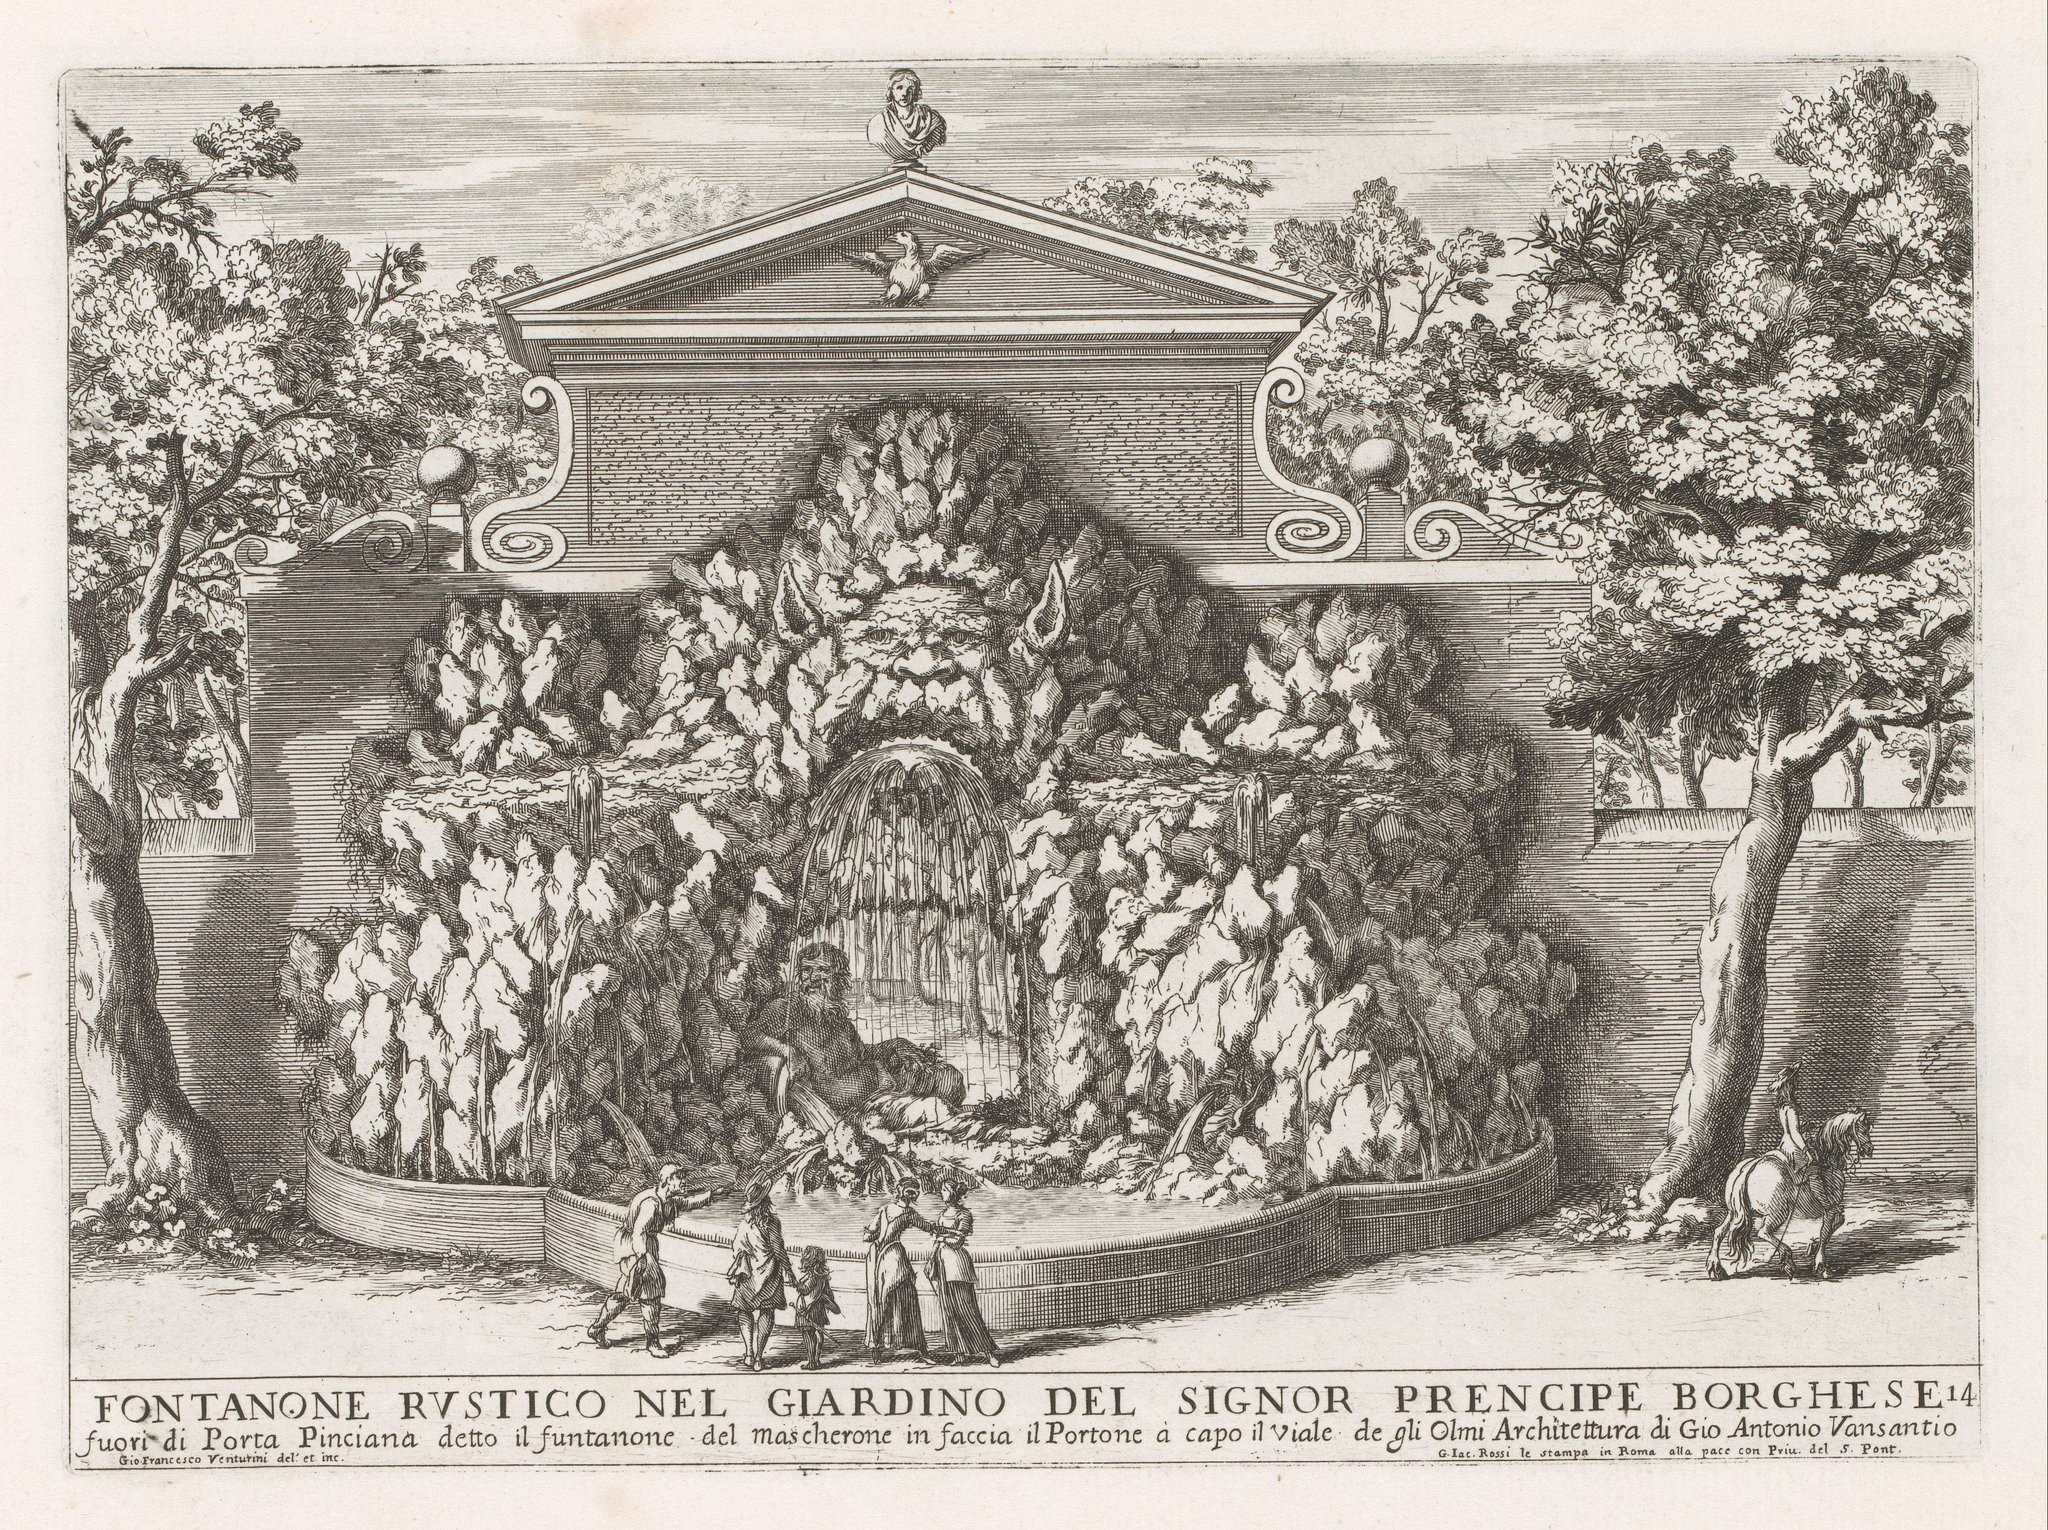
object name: print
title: Fontein in de Villa Borghese te Rome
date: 1653-1691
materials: paper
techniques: etching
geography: italy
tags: ornamental fountain, rome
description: Genummerd rechtsonder: 14. De prent maakt deel uit van een album.